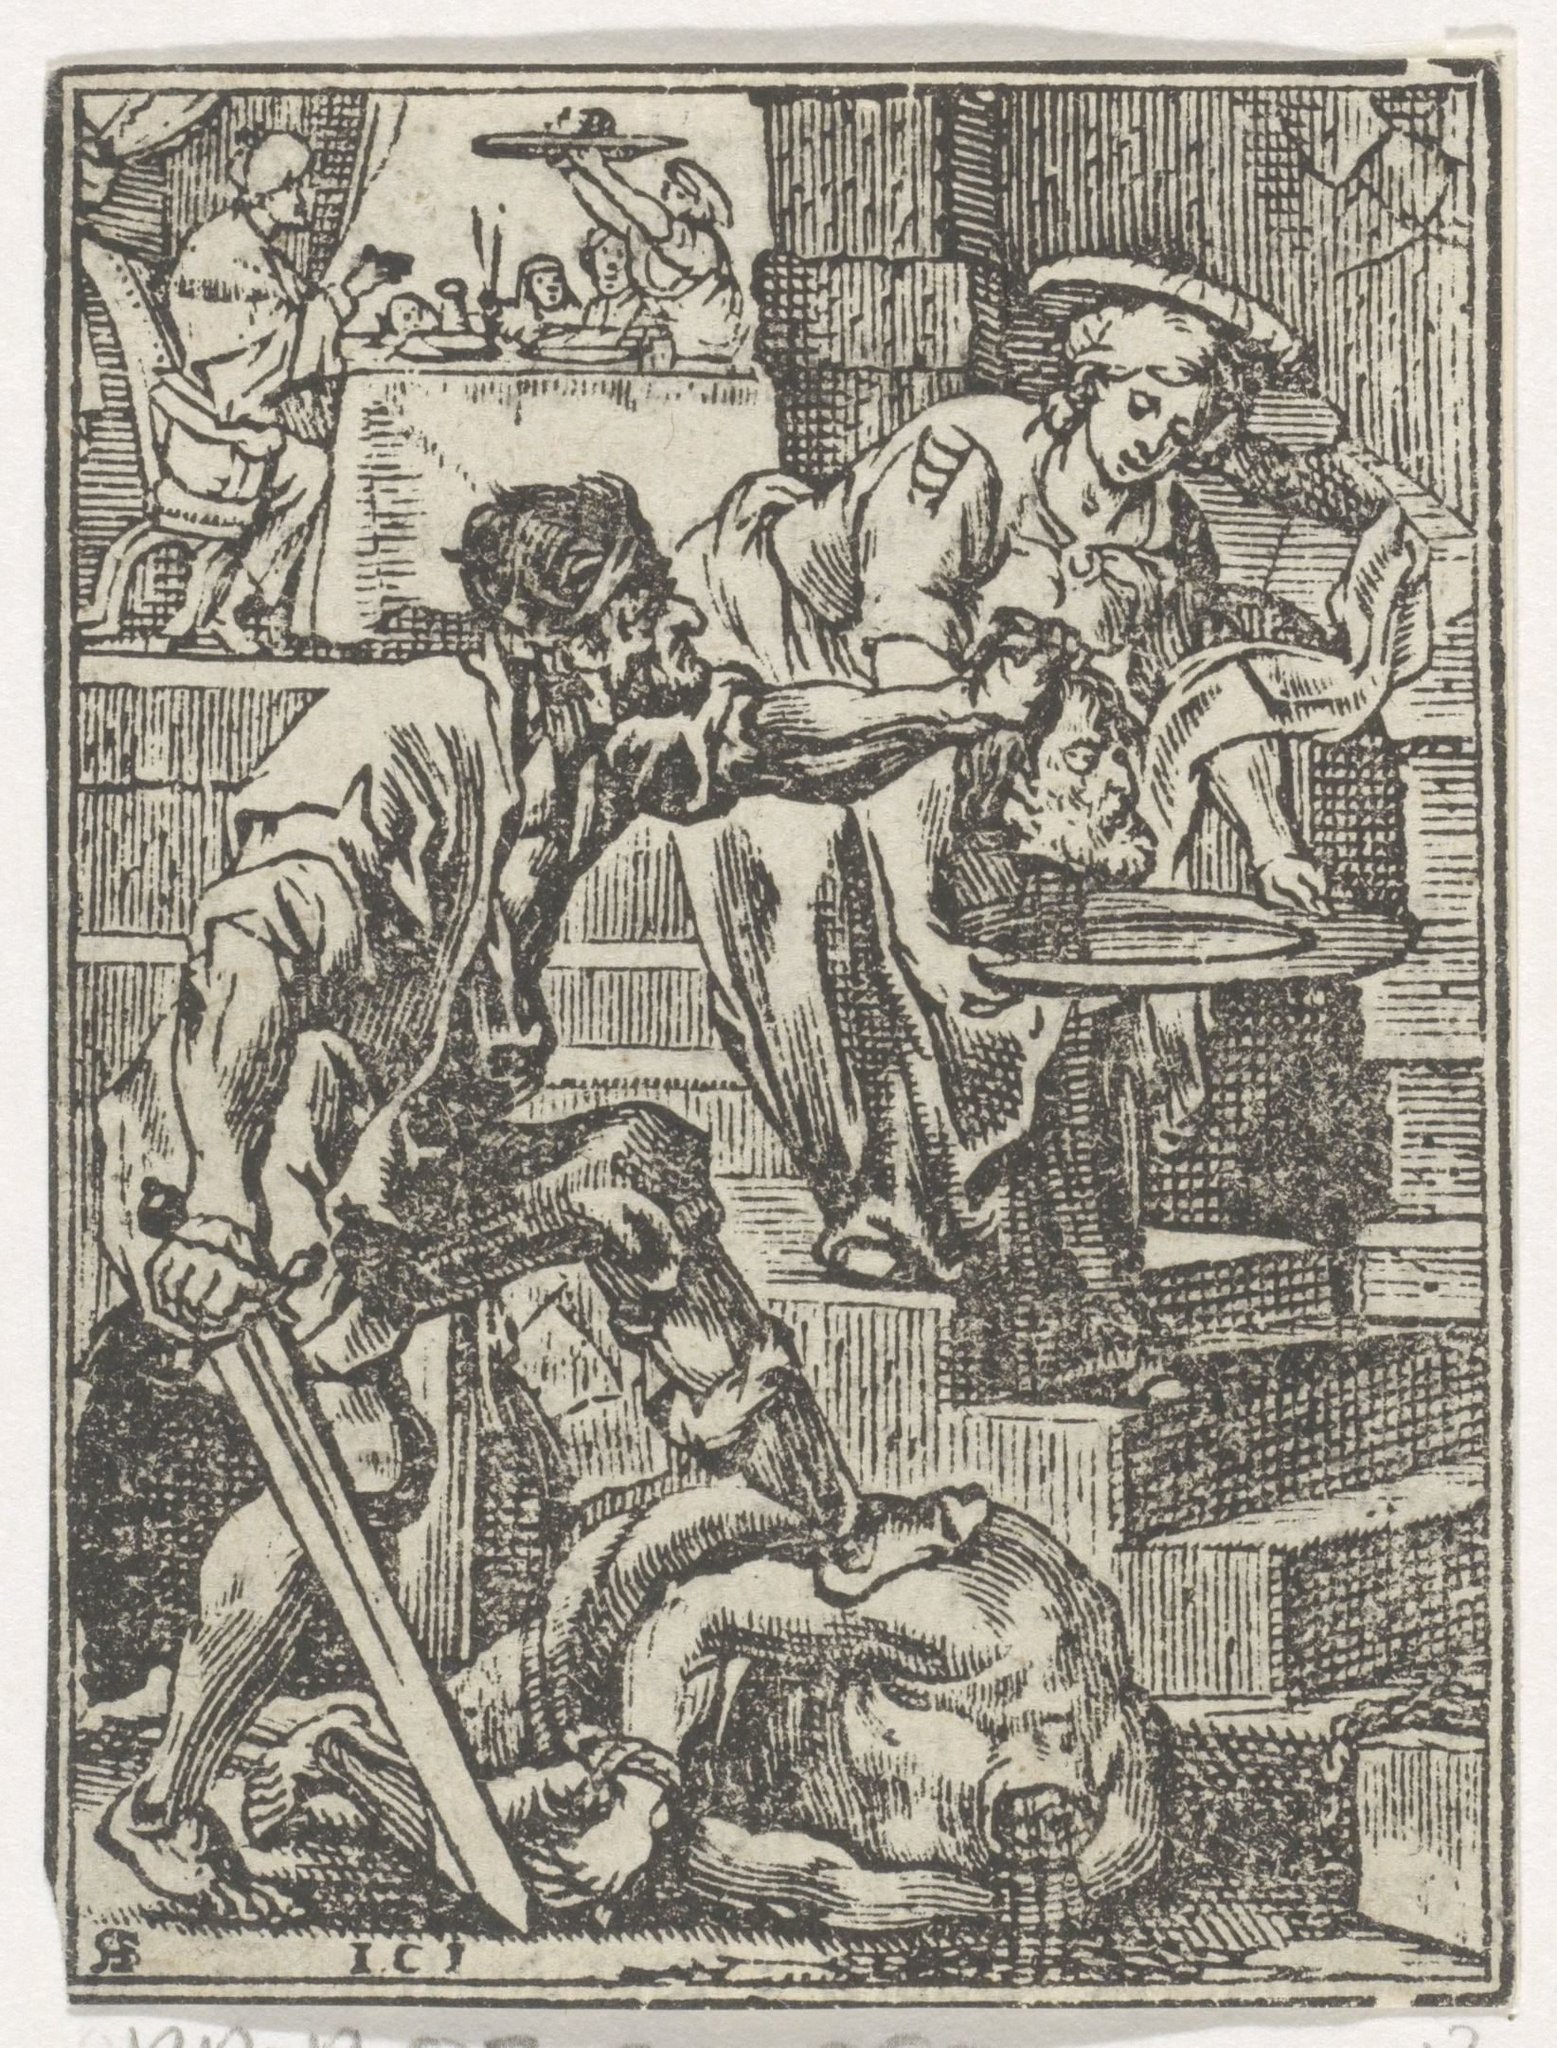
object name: print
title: Onthoofding van Johannnes de Doper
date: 1649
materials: paper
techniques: letterpress printing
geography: antwerp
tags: the beheading of john the baptist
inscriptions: collector's mark: Lugt 2228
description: De beul heeft net het hoofd van de Johannes de Doper afgehouwen en legt het op de schaal die wordt vastgehouden door Salome. De beul staat met één voet op het onthoofde lichaam van Johannes de Doper waarvan de handen zijn vastgebonden.